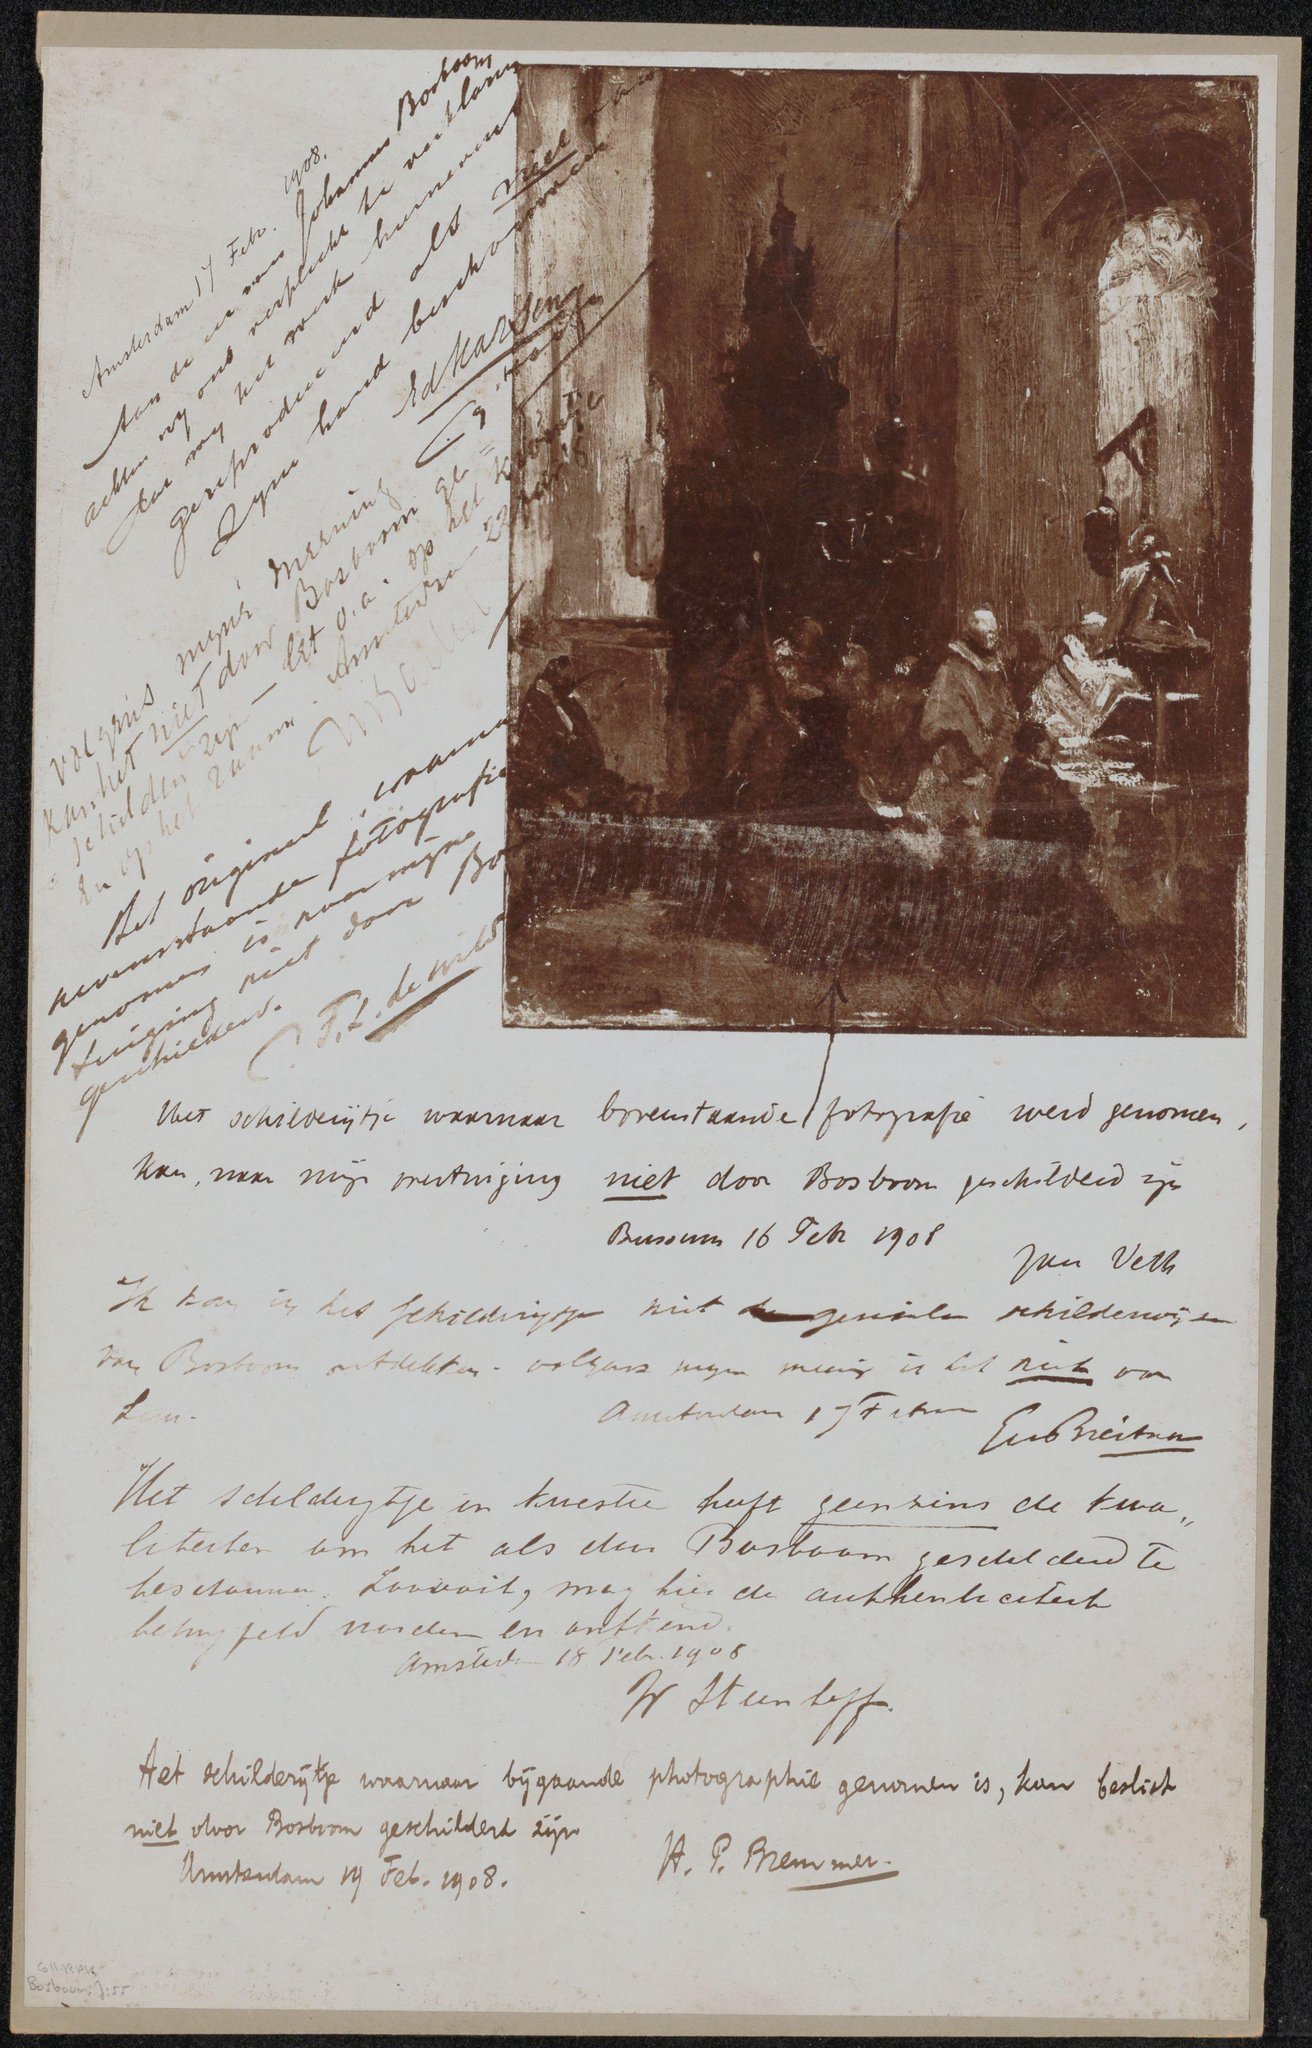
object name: photograph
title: Foto met aantekeningen van verschillende kunstenaars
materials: photographic support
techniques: daylight paper print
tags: the hague, johannes bosboom, painting (including book-illumination, miniature-painting)